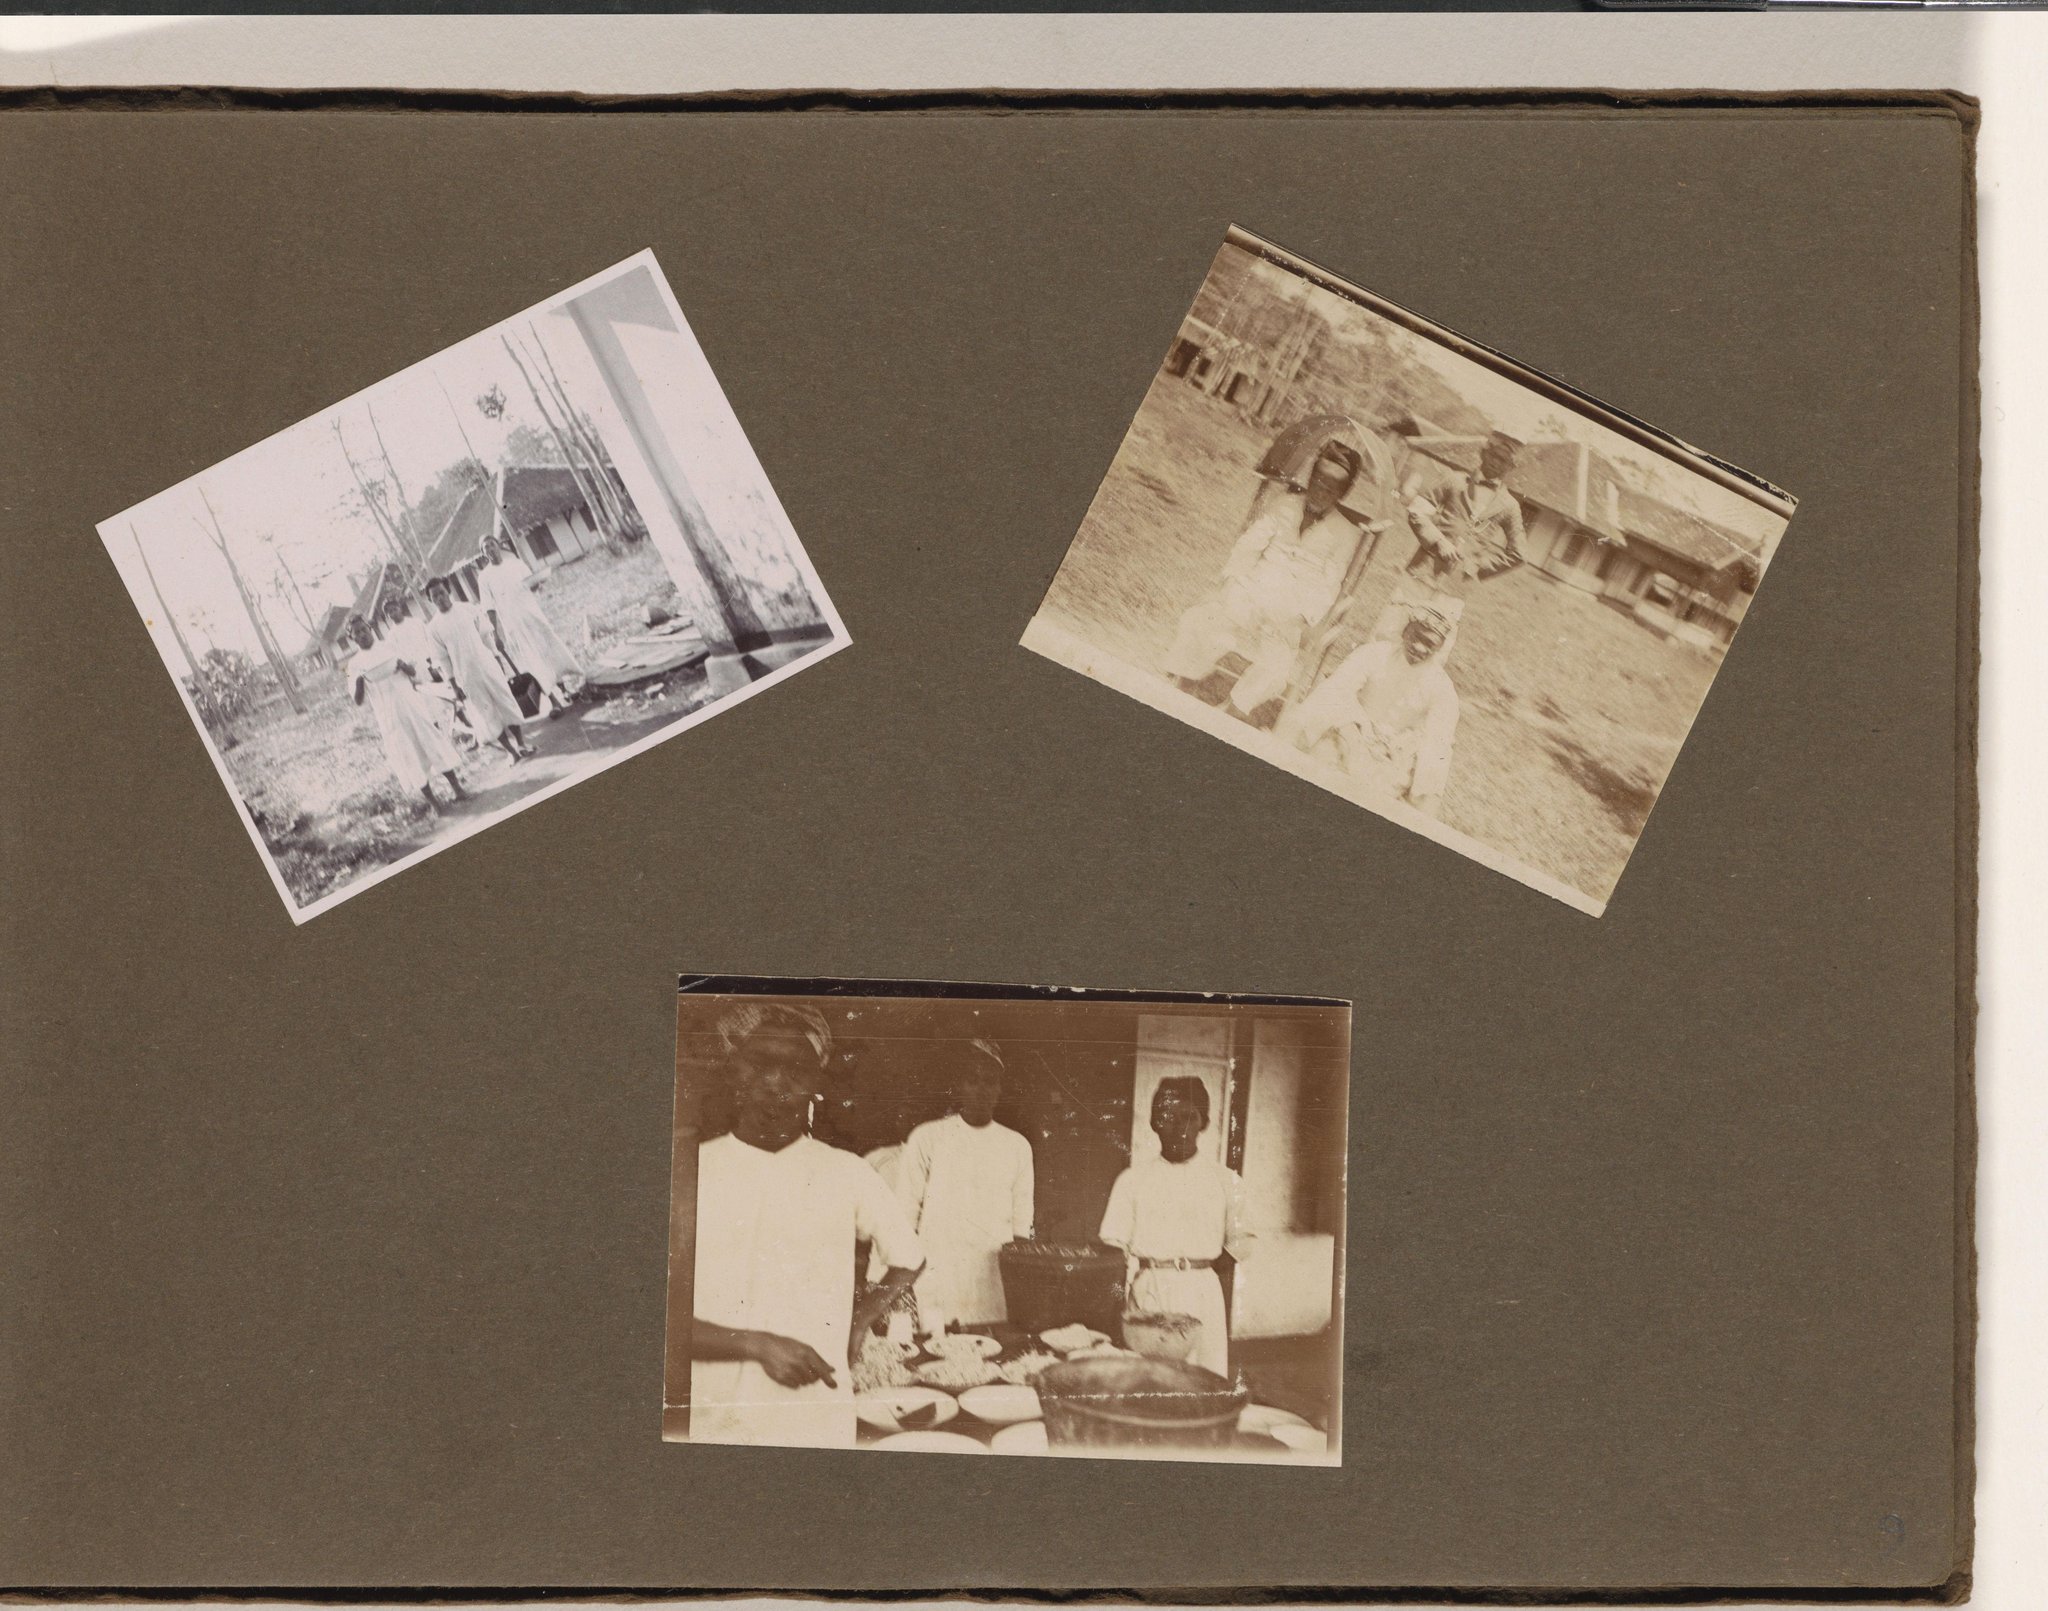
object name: album leaf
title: Leprozenkolonie Danaradja: personeel en bezoeker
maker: Anonymous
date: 1922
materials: cardboard, photographic support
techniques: gelatin silver print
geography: kelet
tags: patient, sick person, chair, eating, leprosy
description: Albumblad met drie foto's: linksboven en onder vermoedelijk personeel met etenswaren, rechtsboven vermoedelijk verplegers bij een bezoeker in een stoel met afdak. Onderdeel van Fotoalbum leprozenkolonie Danaradja en familieopnames.